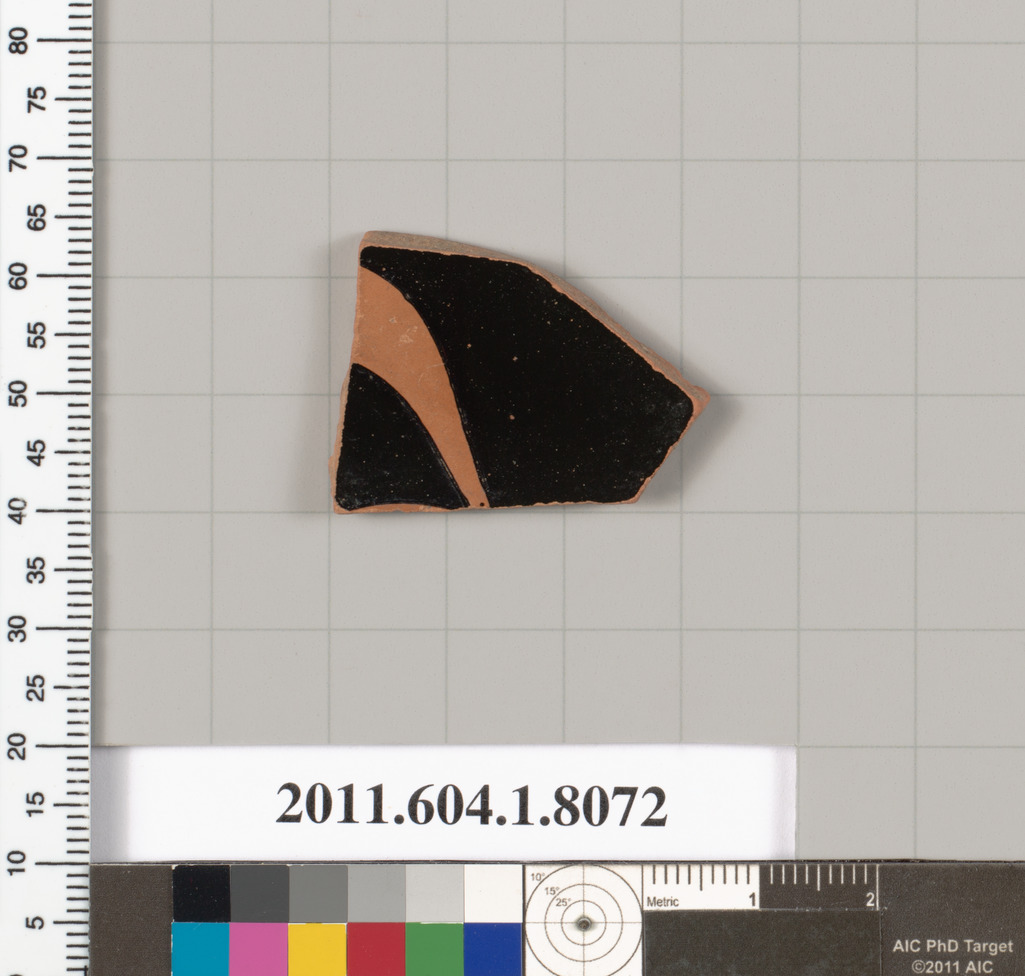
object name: kylix fragment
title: Terracotta fragment of a kylix (drinking cup)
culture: greek, attic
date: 510-500 BCE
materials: terracotta